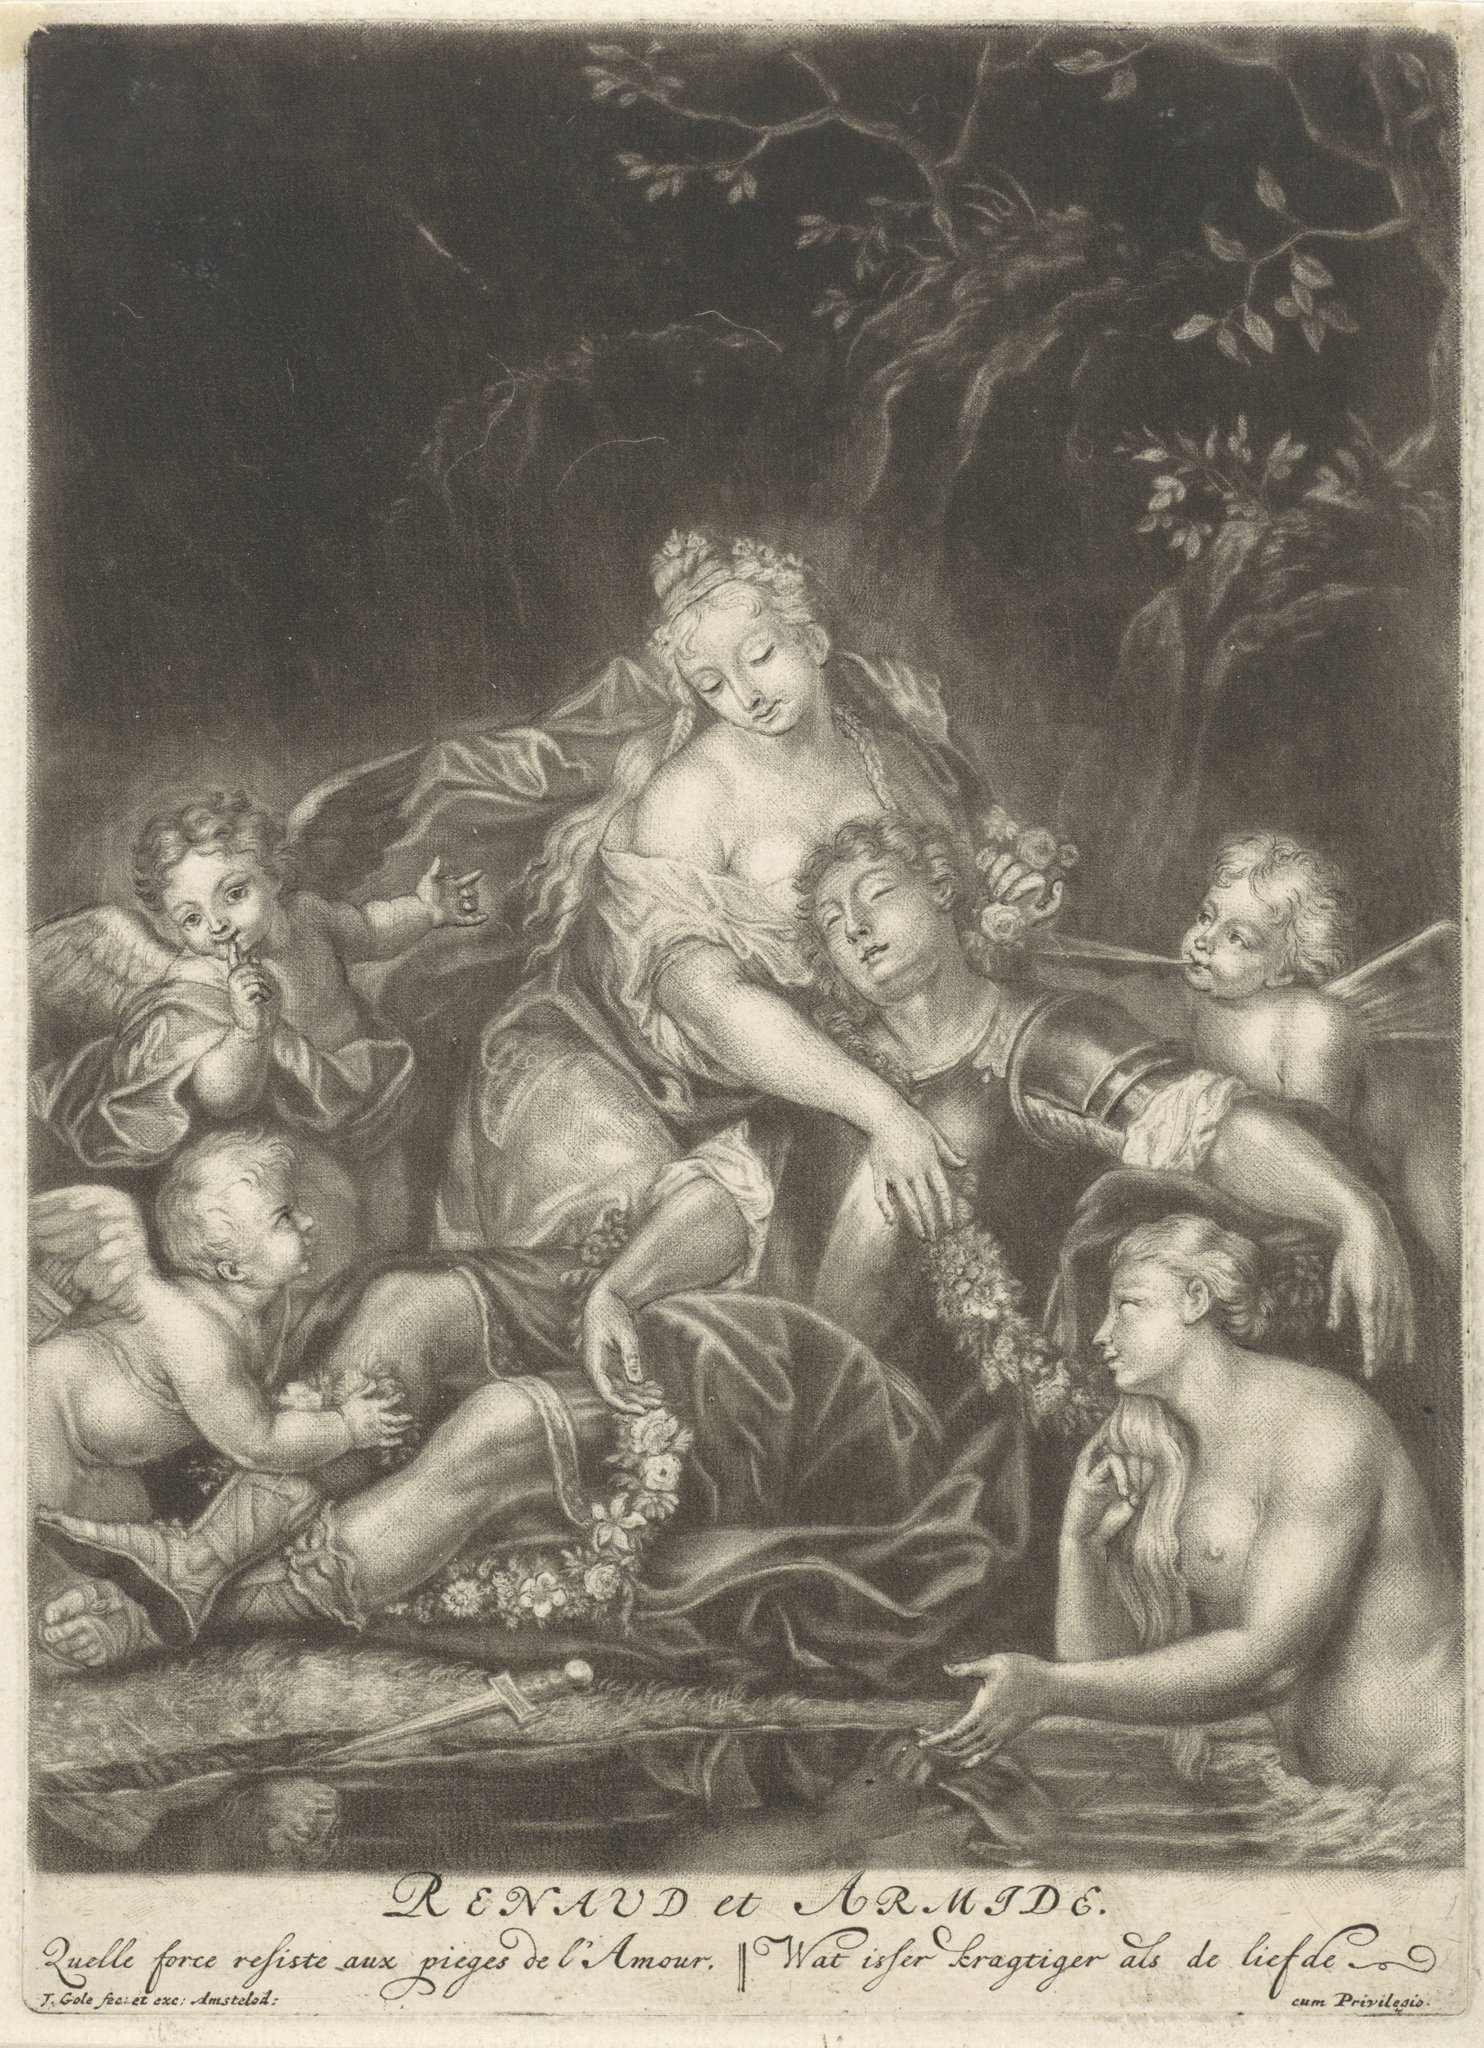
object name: print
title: Armida en de slapende Rinaldo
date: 1670-1724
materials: paper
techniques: etching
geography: amsterdam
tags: rinaldo, armida, (scenes from) specific works of literature: tasso, gerusalemme liberata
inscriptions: collector's mark: Lugt 2228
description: Rinaldo slaapt aan de oever van de rivier Orontes. Armida knielt verliefd naast hem neer. Een aantal putti versiert de plek met bloemranken en manen tot stilte zodat Rinaldo niet wakker wordt.